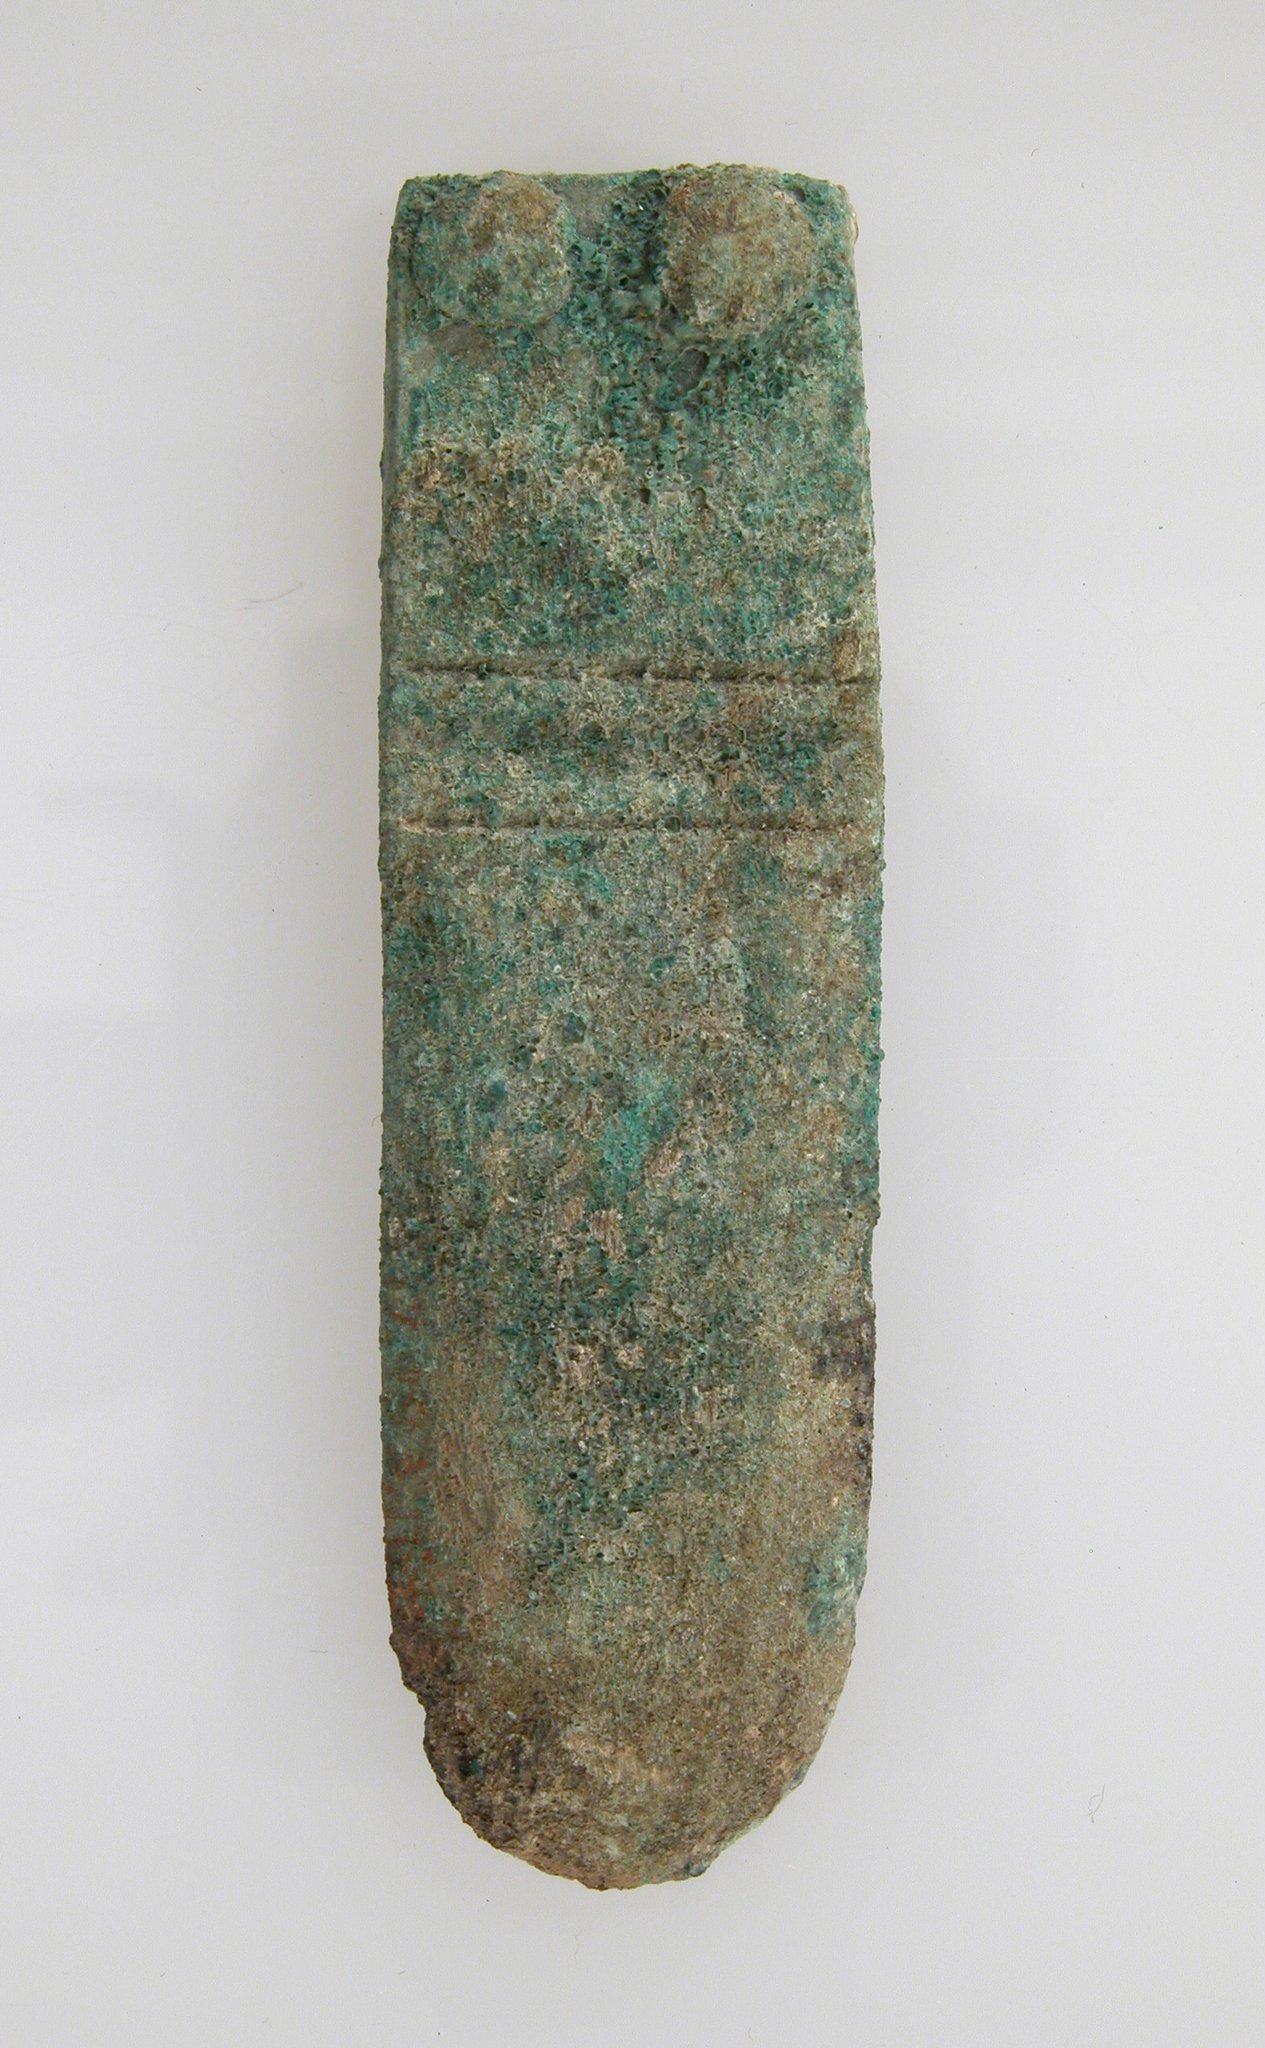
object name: ferret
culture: langobardic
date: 601-700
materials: copper alloy